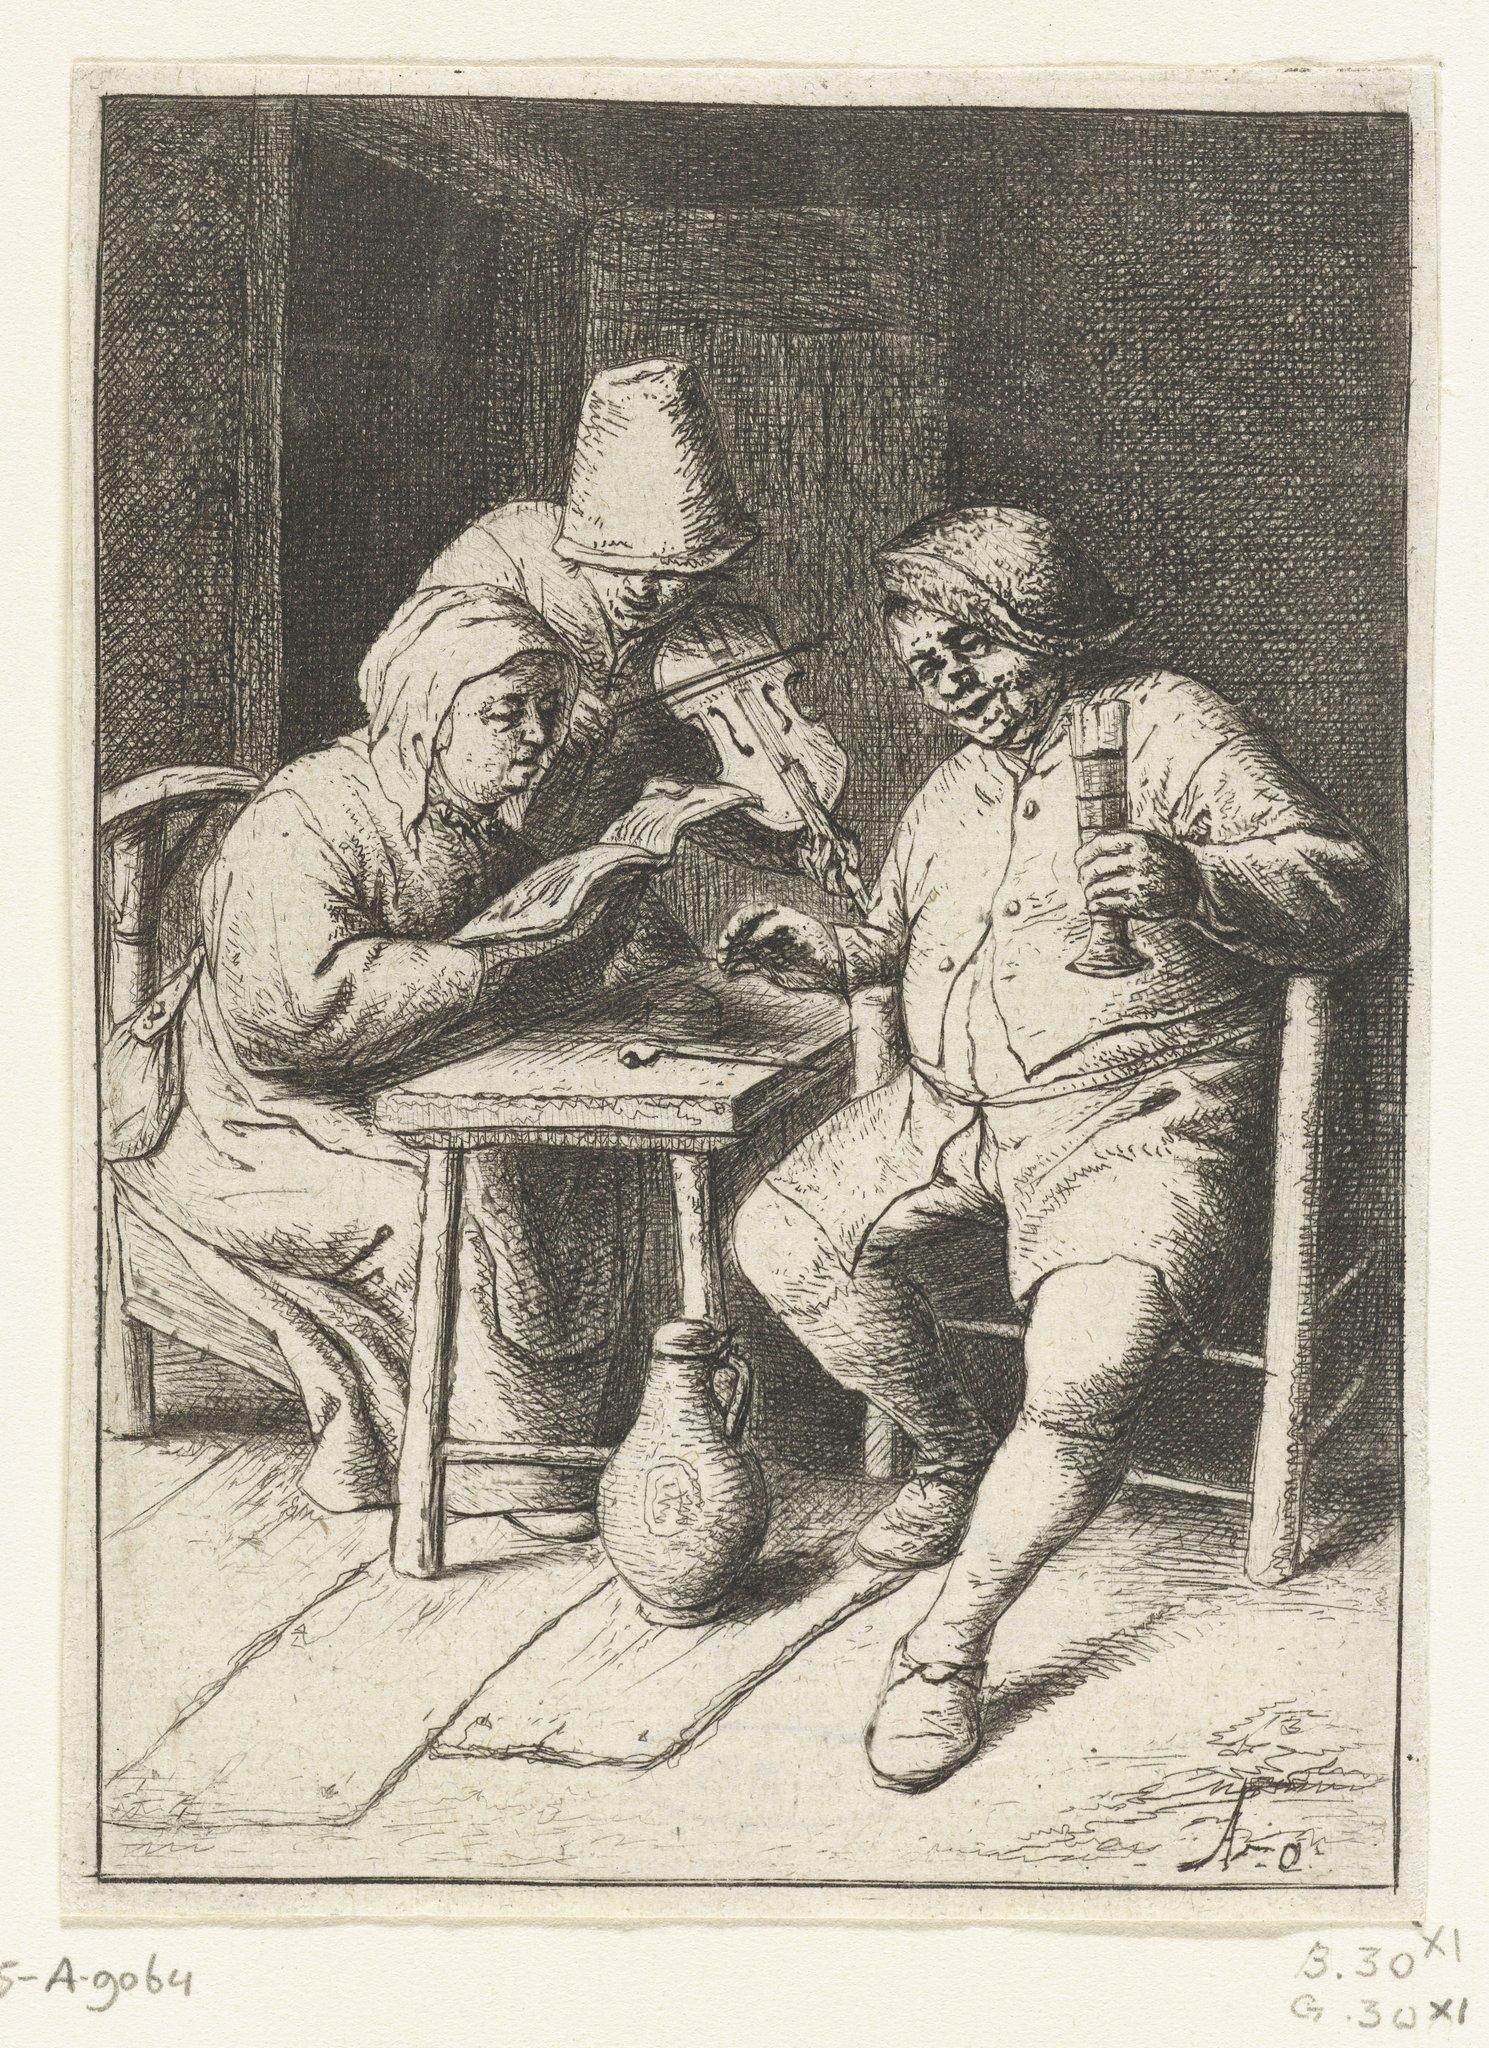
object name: print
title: Het concert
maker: adriaen van ostade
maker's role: draughtsman, painter, print maker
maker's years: 1610-1685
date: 1651-1655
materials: paper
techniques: etching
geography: haarlem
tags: instrumental and vocal music together, violin, fiddle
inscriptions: collector's mark: Lugt 2228a, collector's mark: Lugt 2610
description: De vrouw houdt een boek vast, mogelijk met bladmuziek, en de man tegenover haar heeft een gevuld glas. Bij hen speelt een man viool. Op de grond staat een kruik.